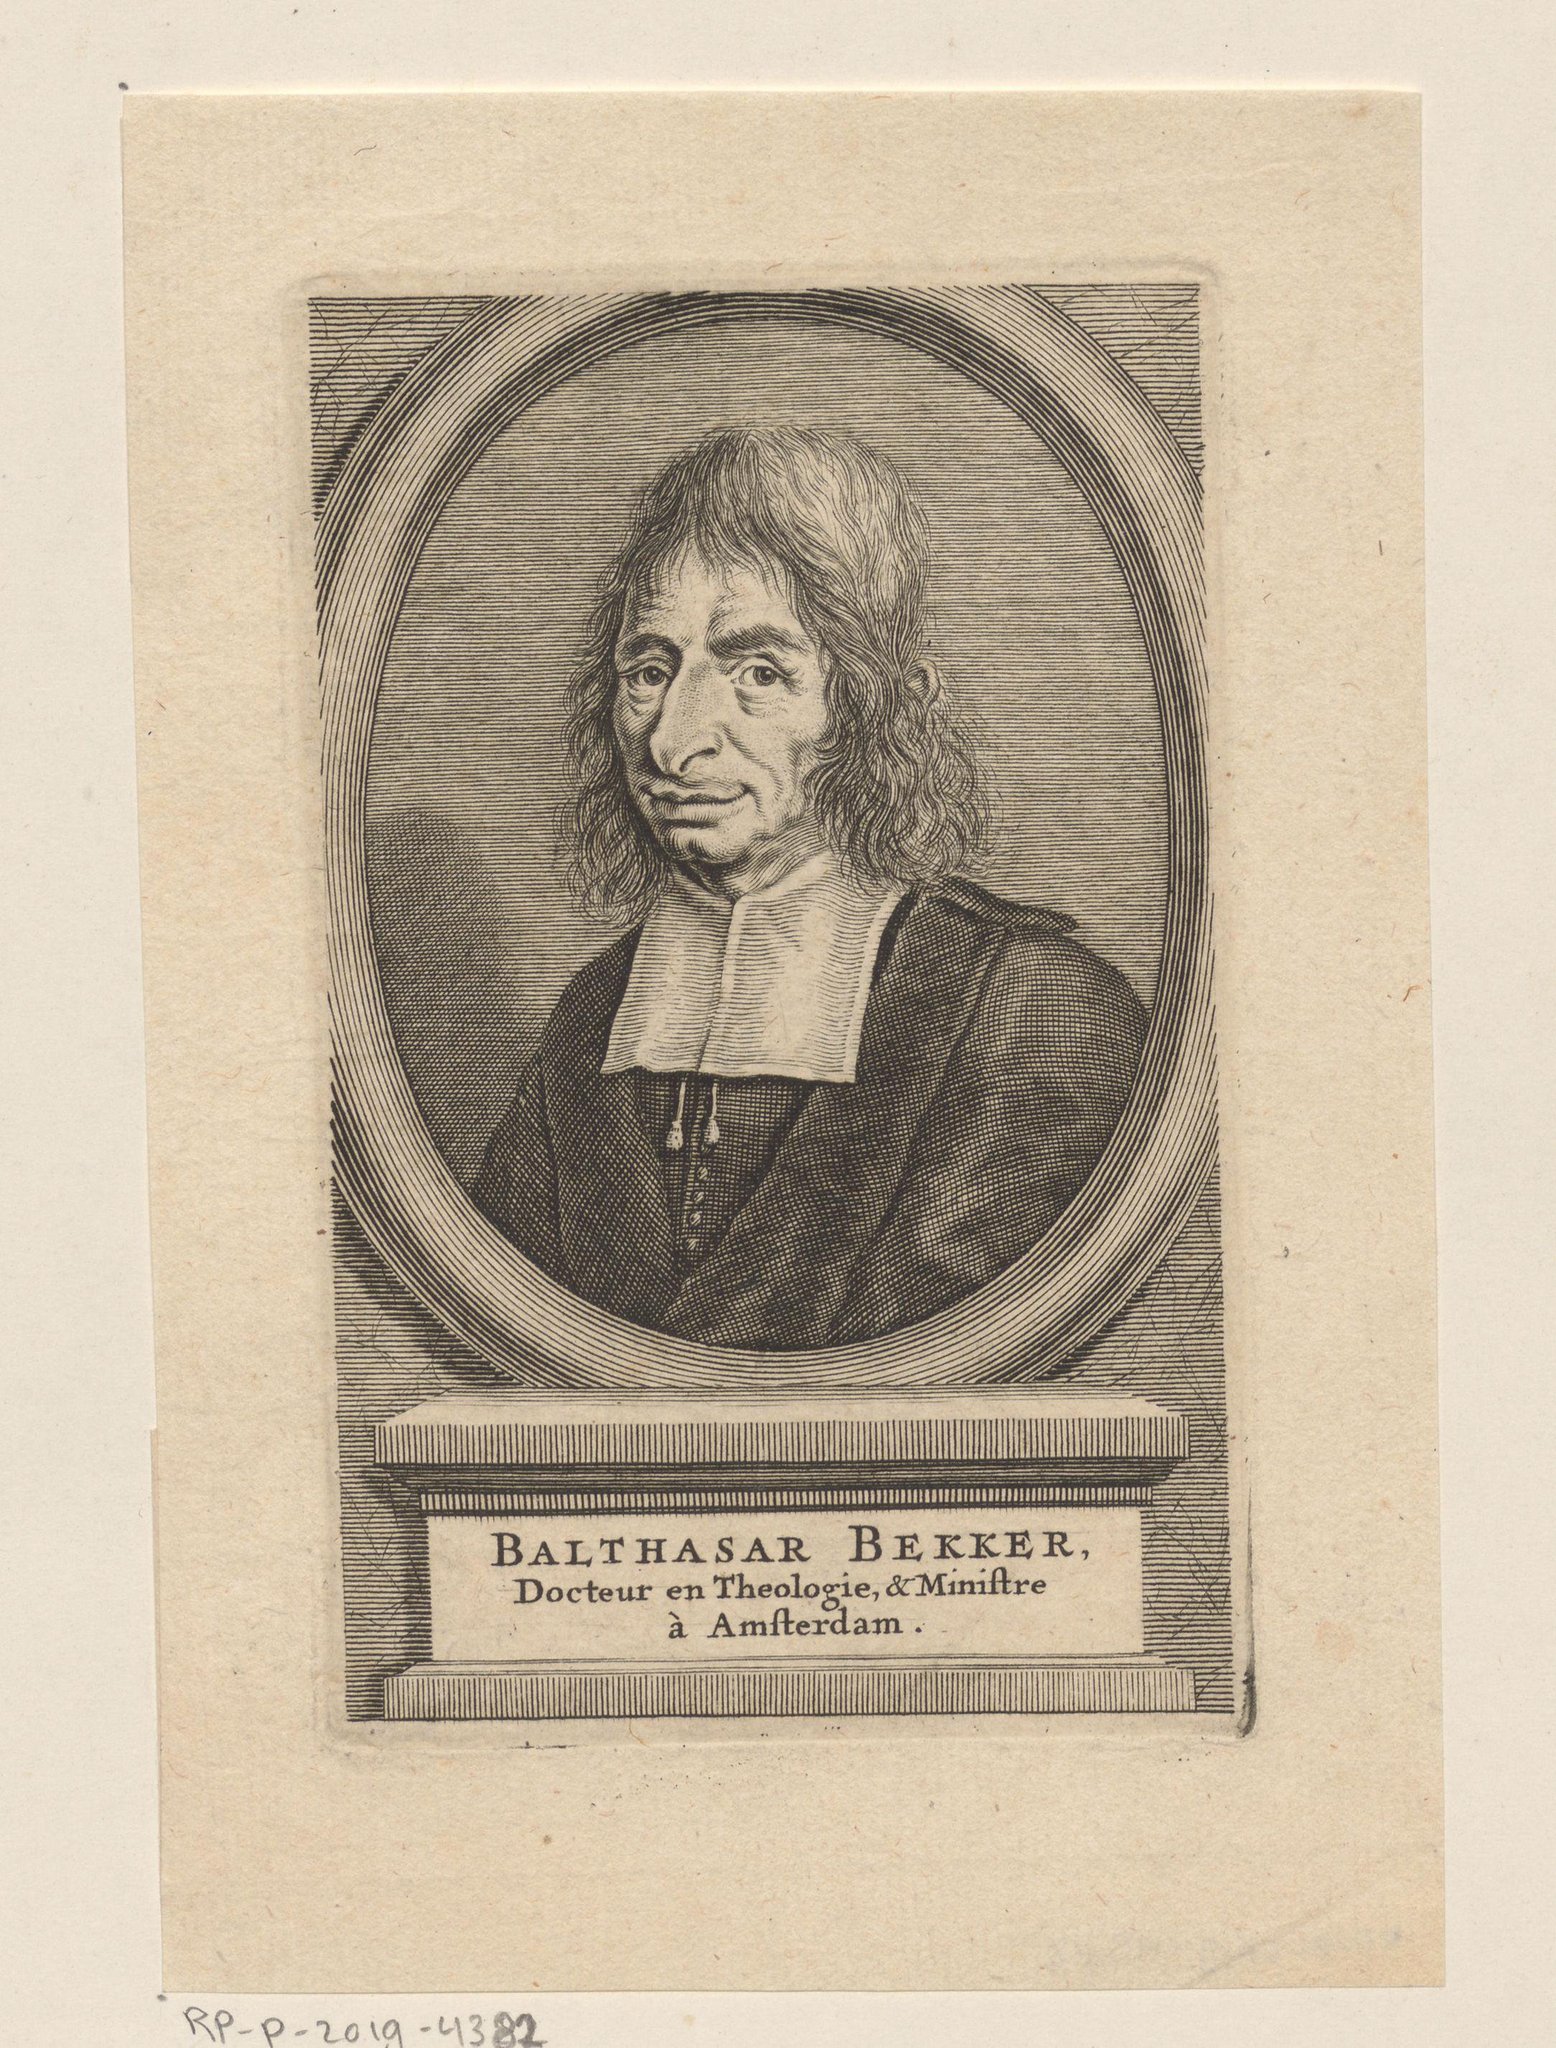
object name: print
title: Portret van Balthasar Bekker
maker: Anonymous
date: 1680-1749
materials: paper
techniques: engraving, etching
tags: amsterdam, balthasar bekker, historical persons